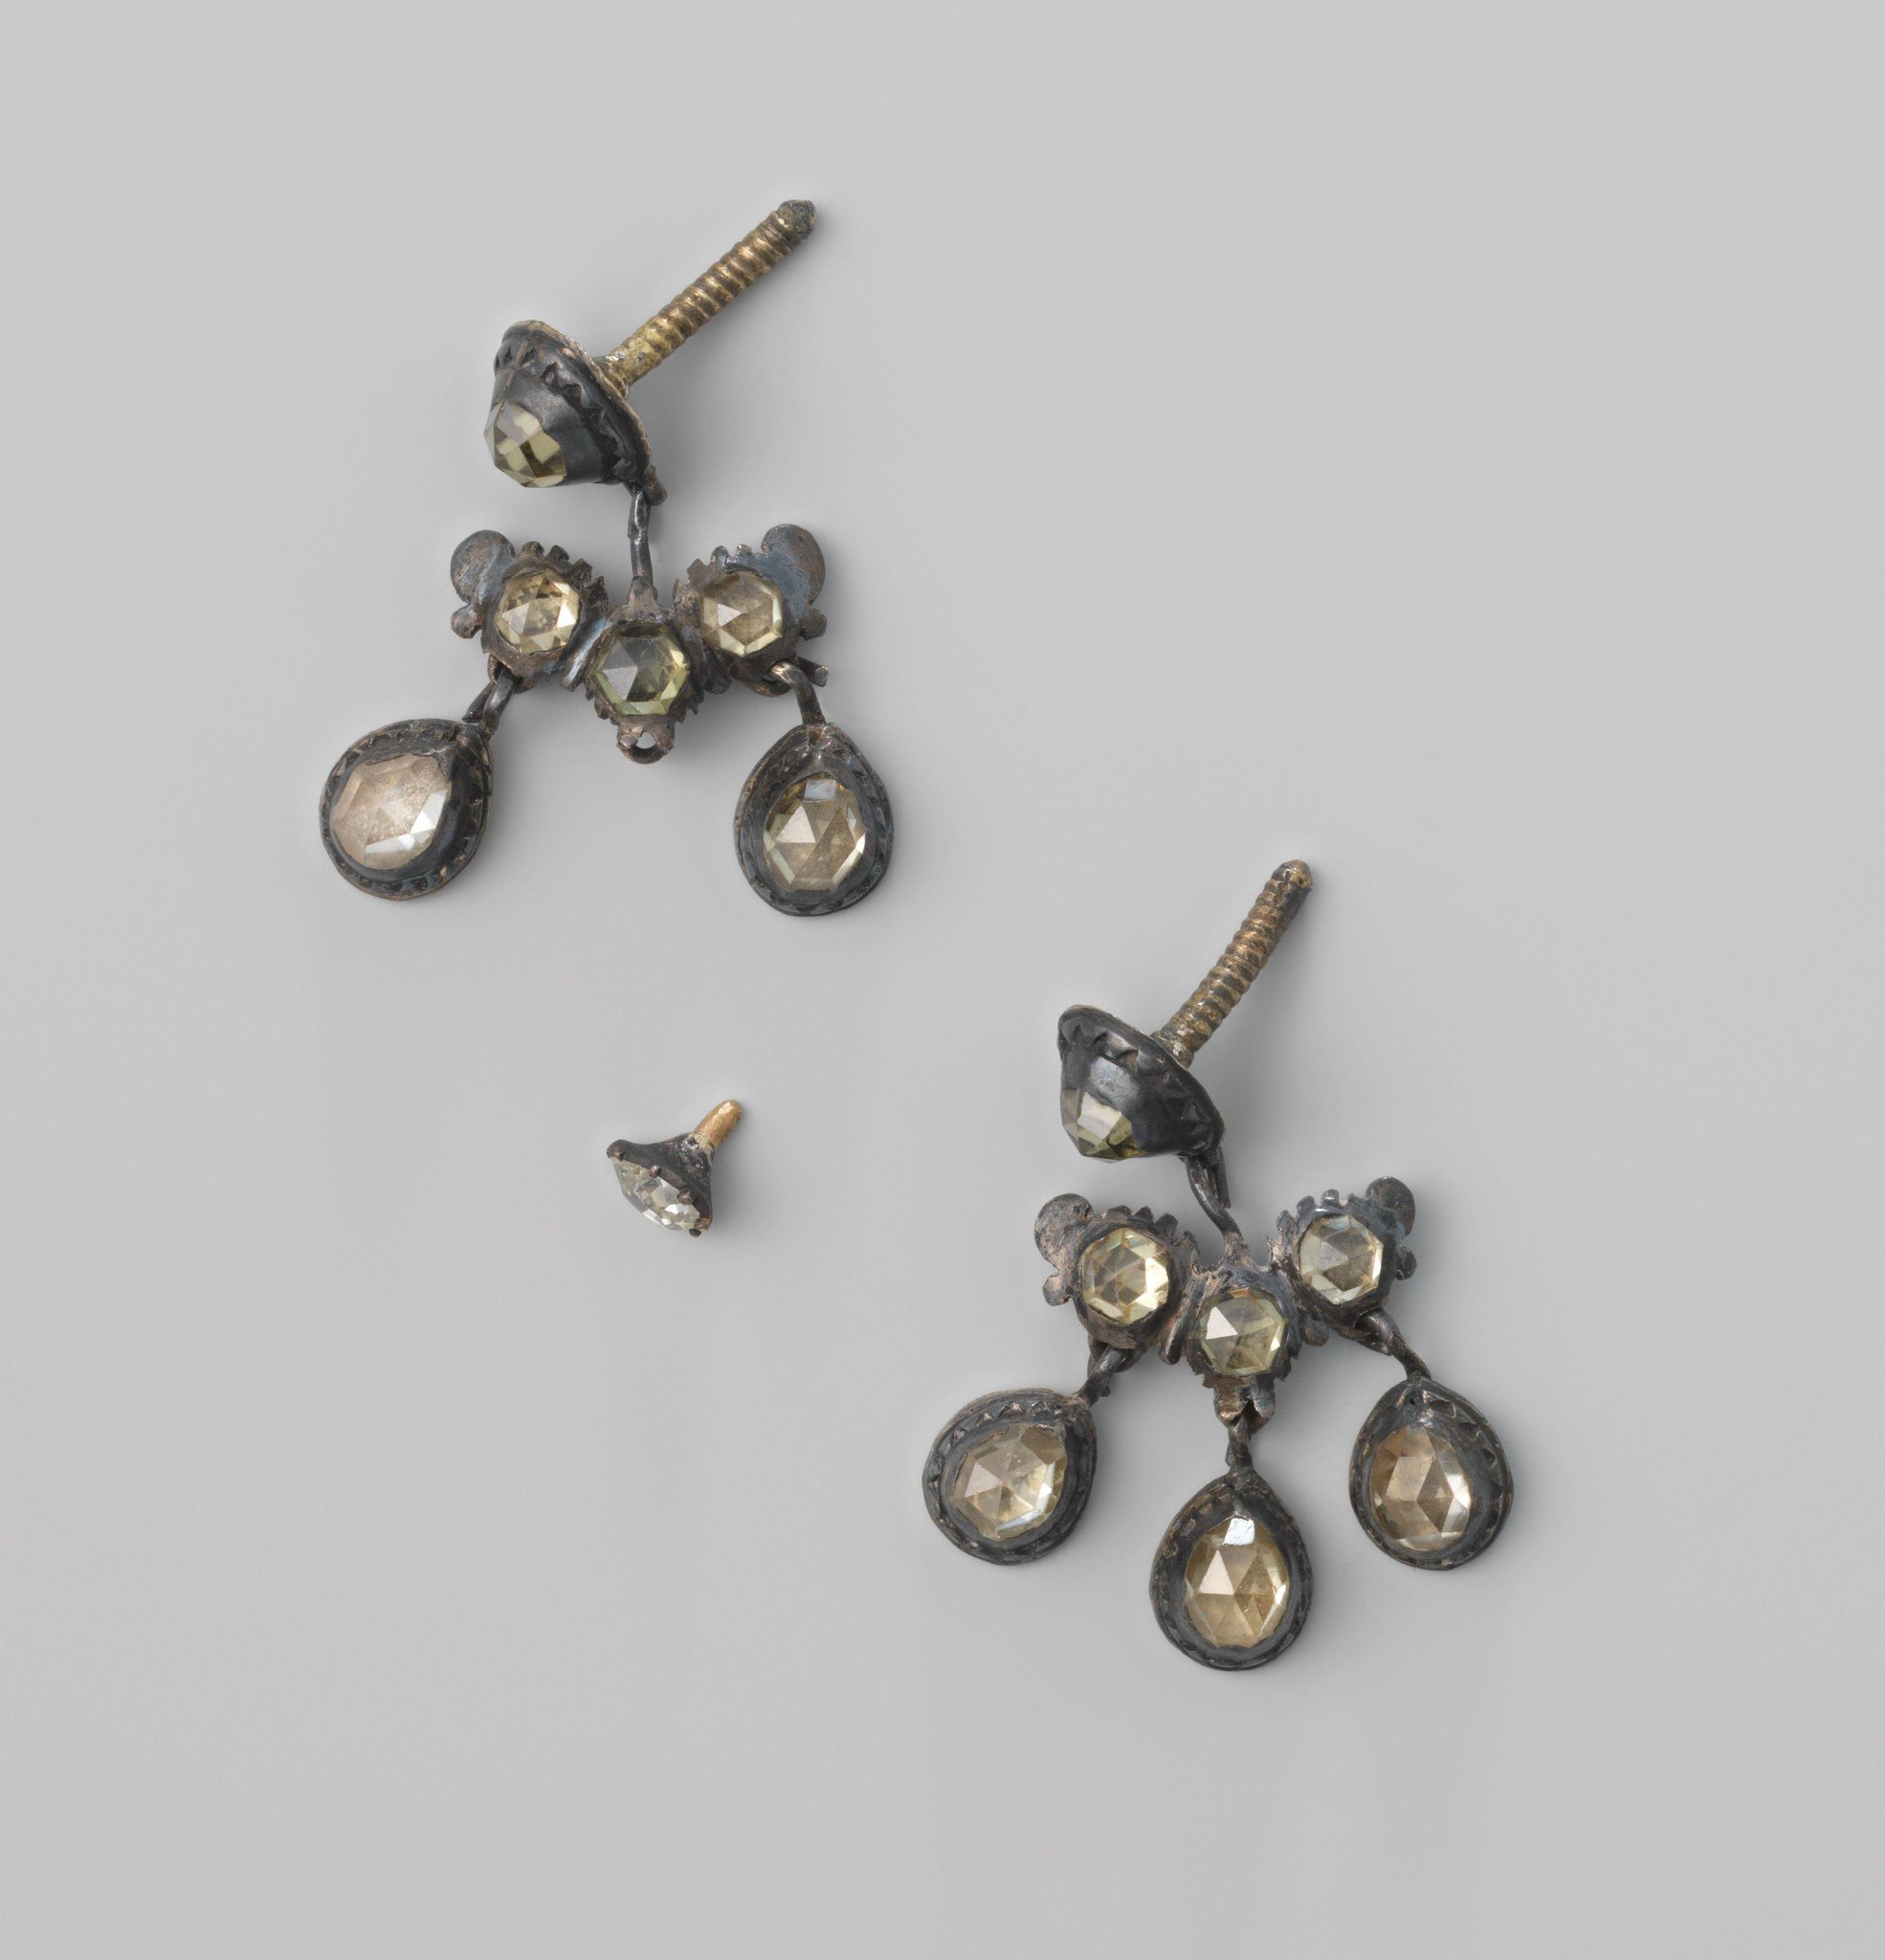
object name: ear ornament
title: Paar oorhangers van zilver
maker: Anonymous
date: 1750-1850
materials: silver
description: Een paar zilveren oorhangers. Versierd met 3 kleine steentjes waaraan 3 grotere stenen in een zetting hangen. Eén hanger heeft een losse steen.